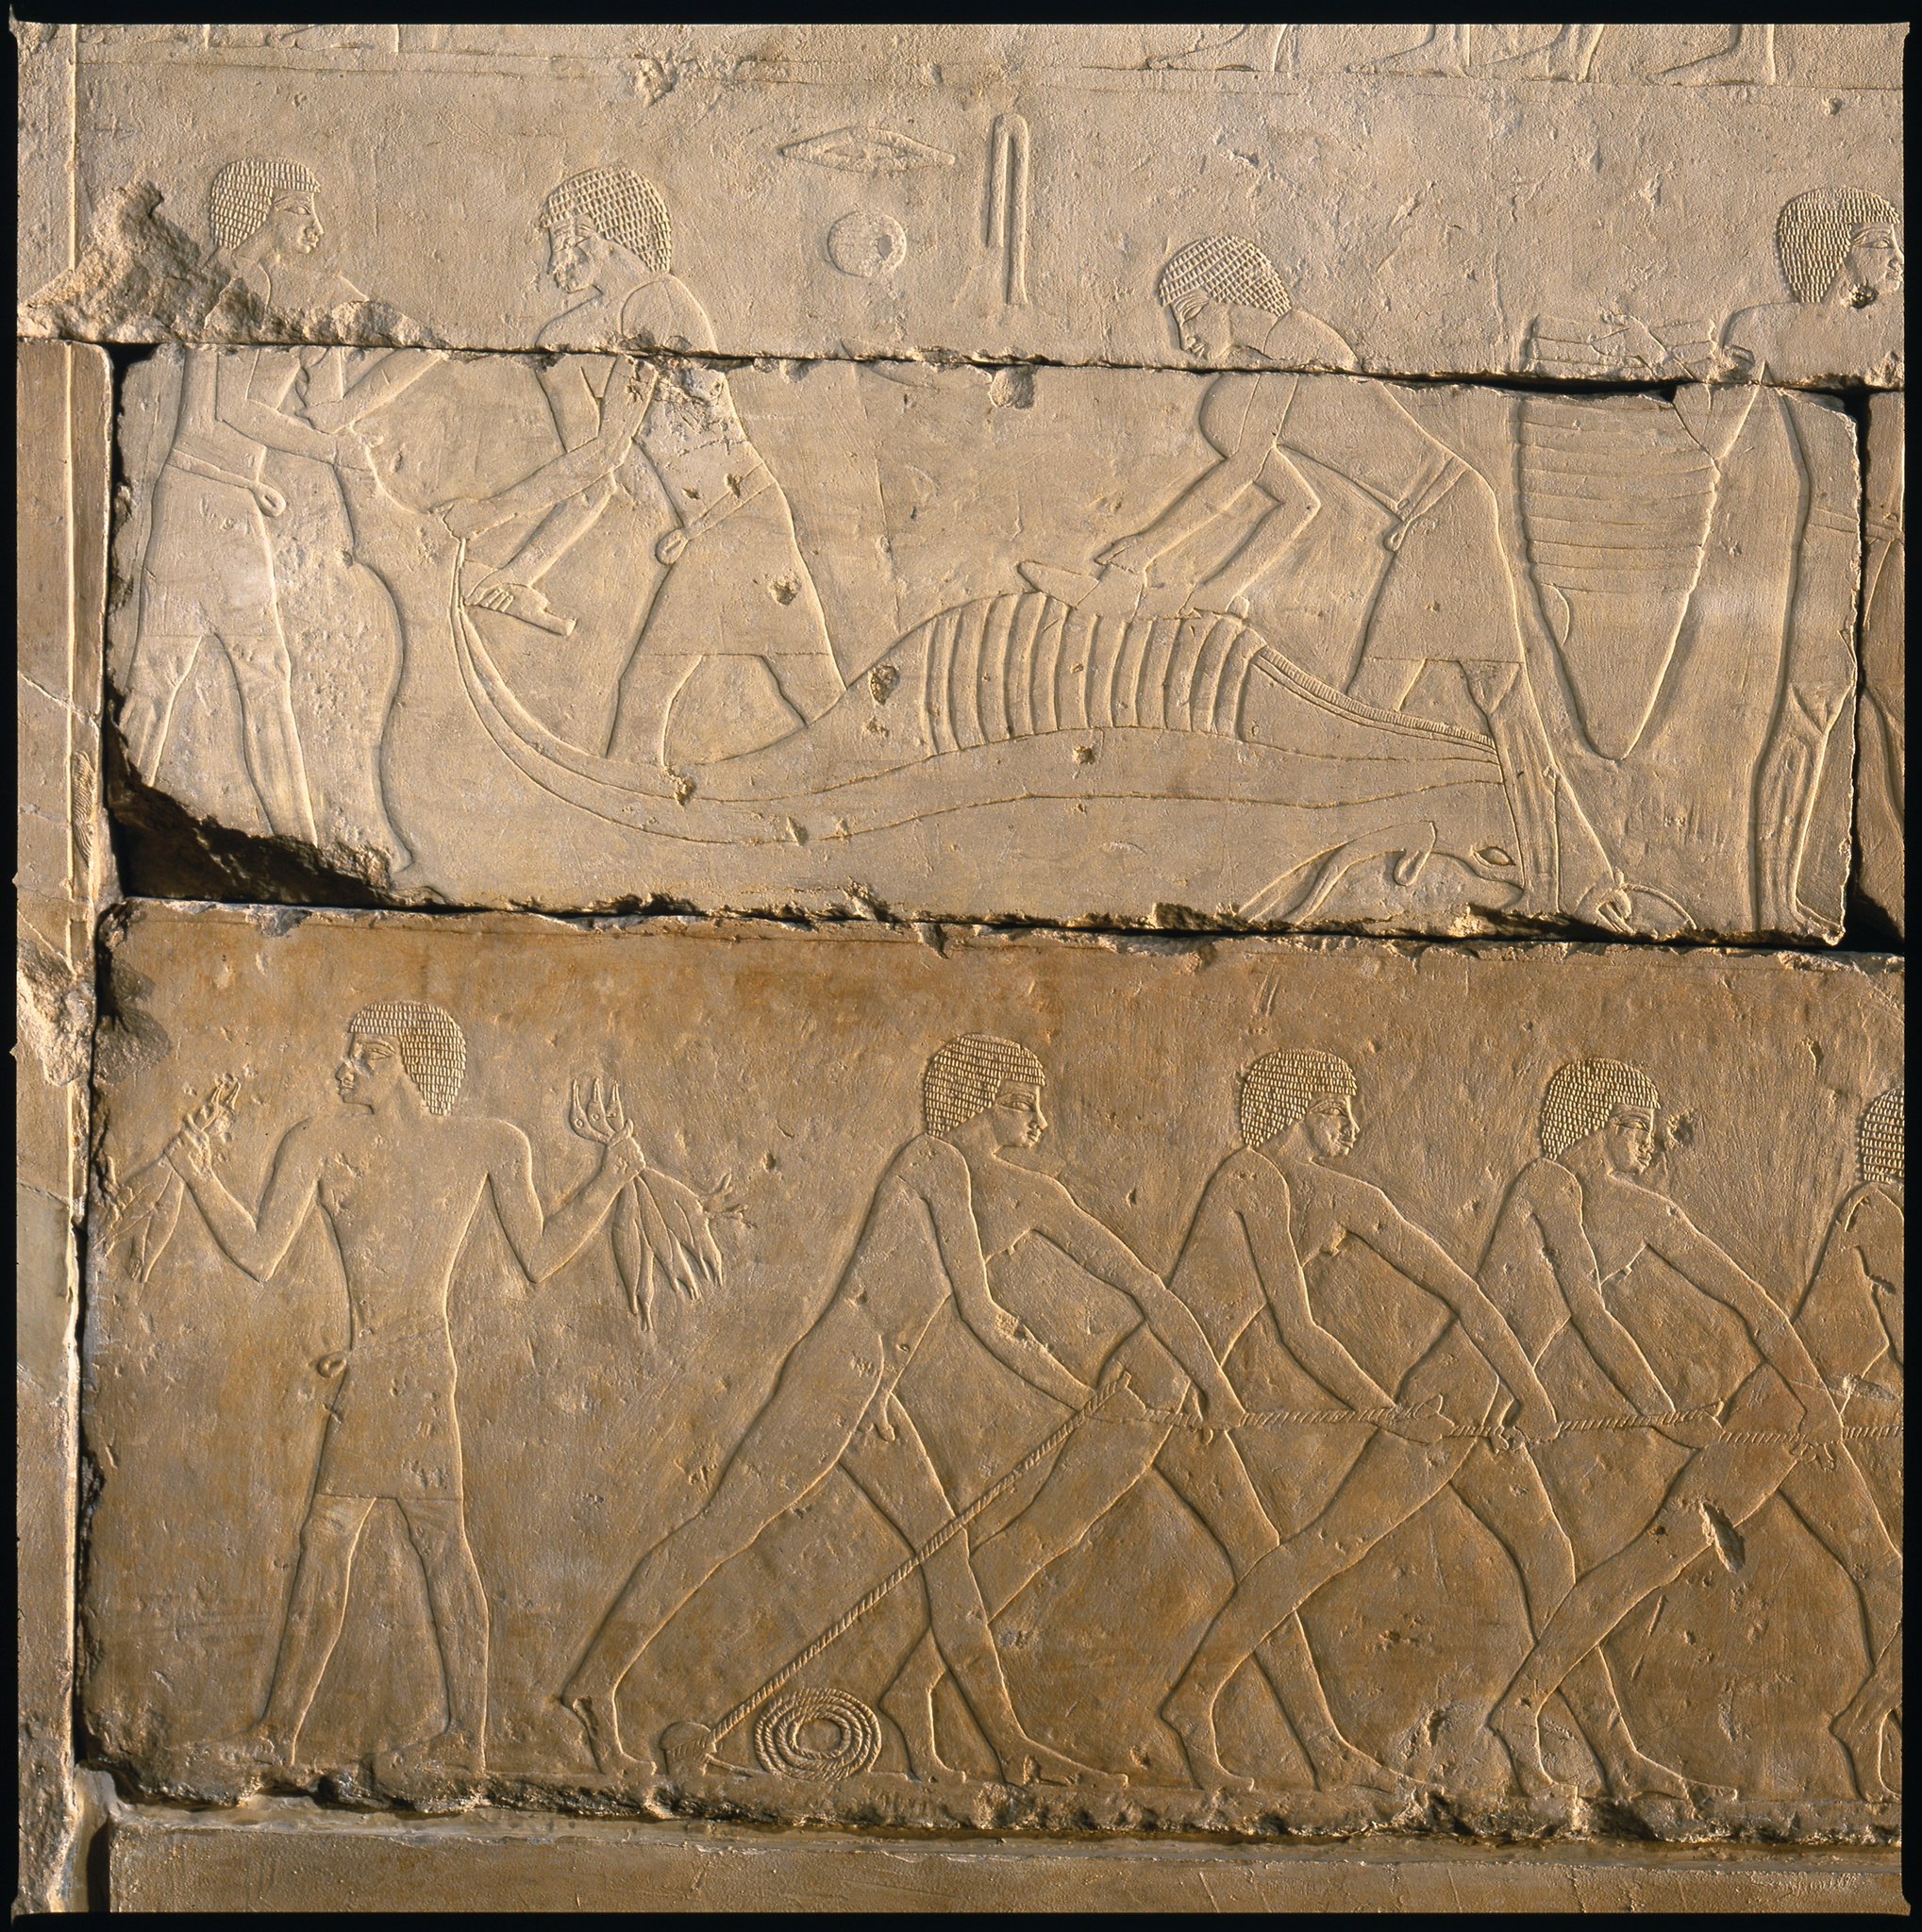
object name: relief, tomb chapel, raemkai, offering bearer, butcher, clapnet, bird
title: Tomb Chapel of Raemkai: West Wall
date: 2446-2389 BCE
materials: limestone, paint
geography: egypt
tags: animals,birds,men,working